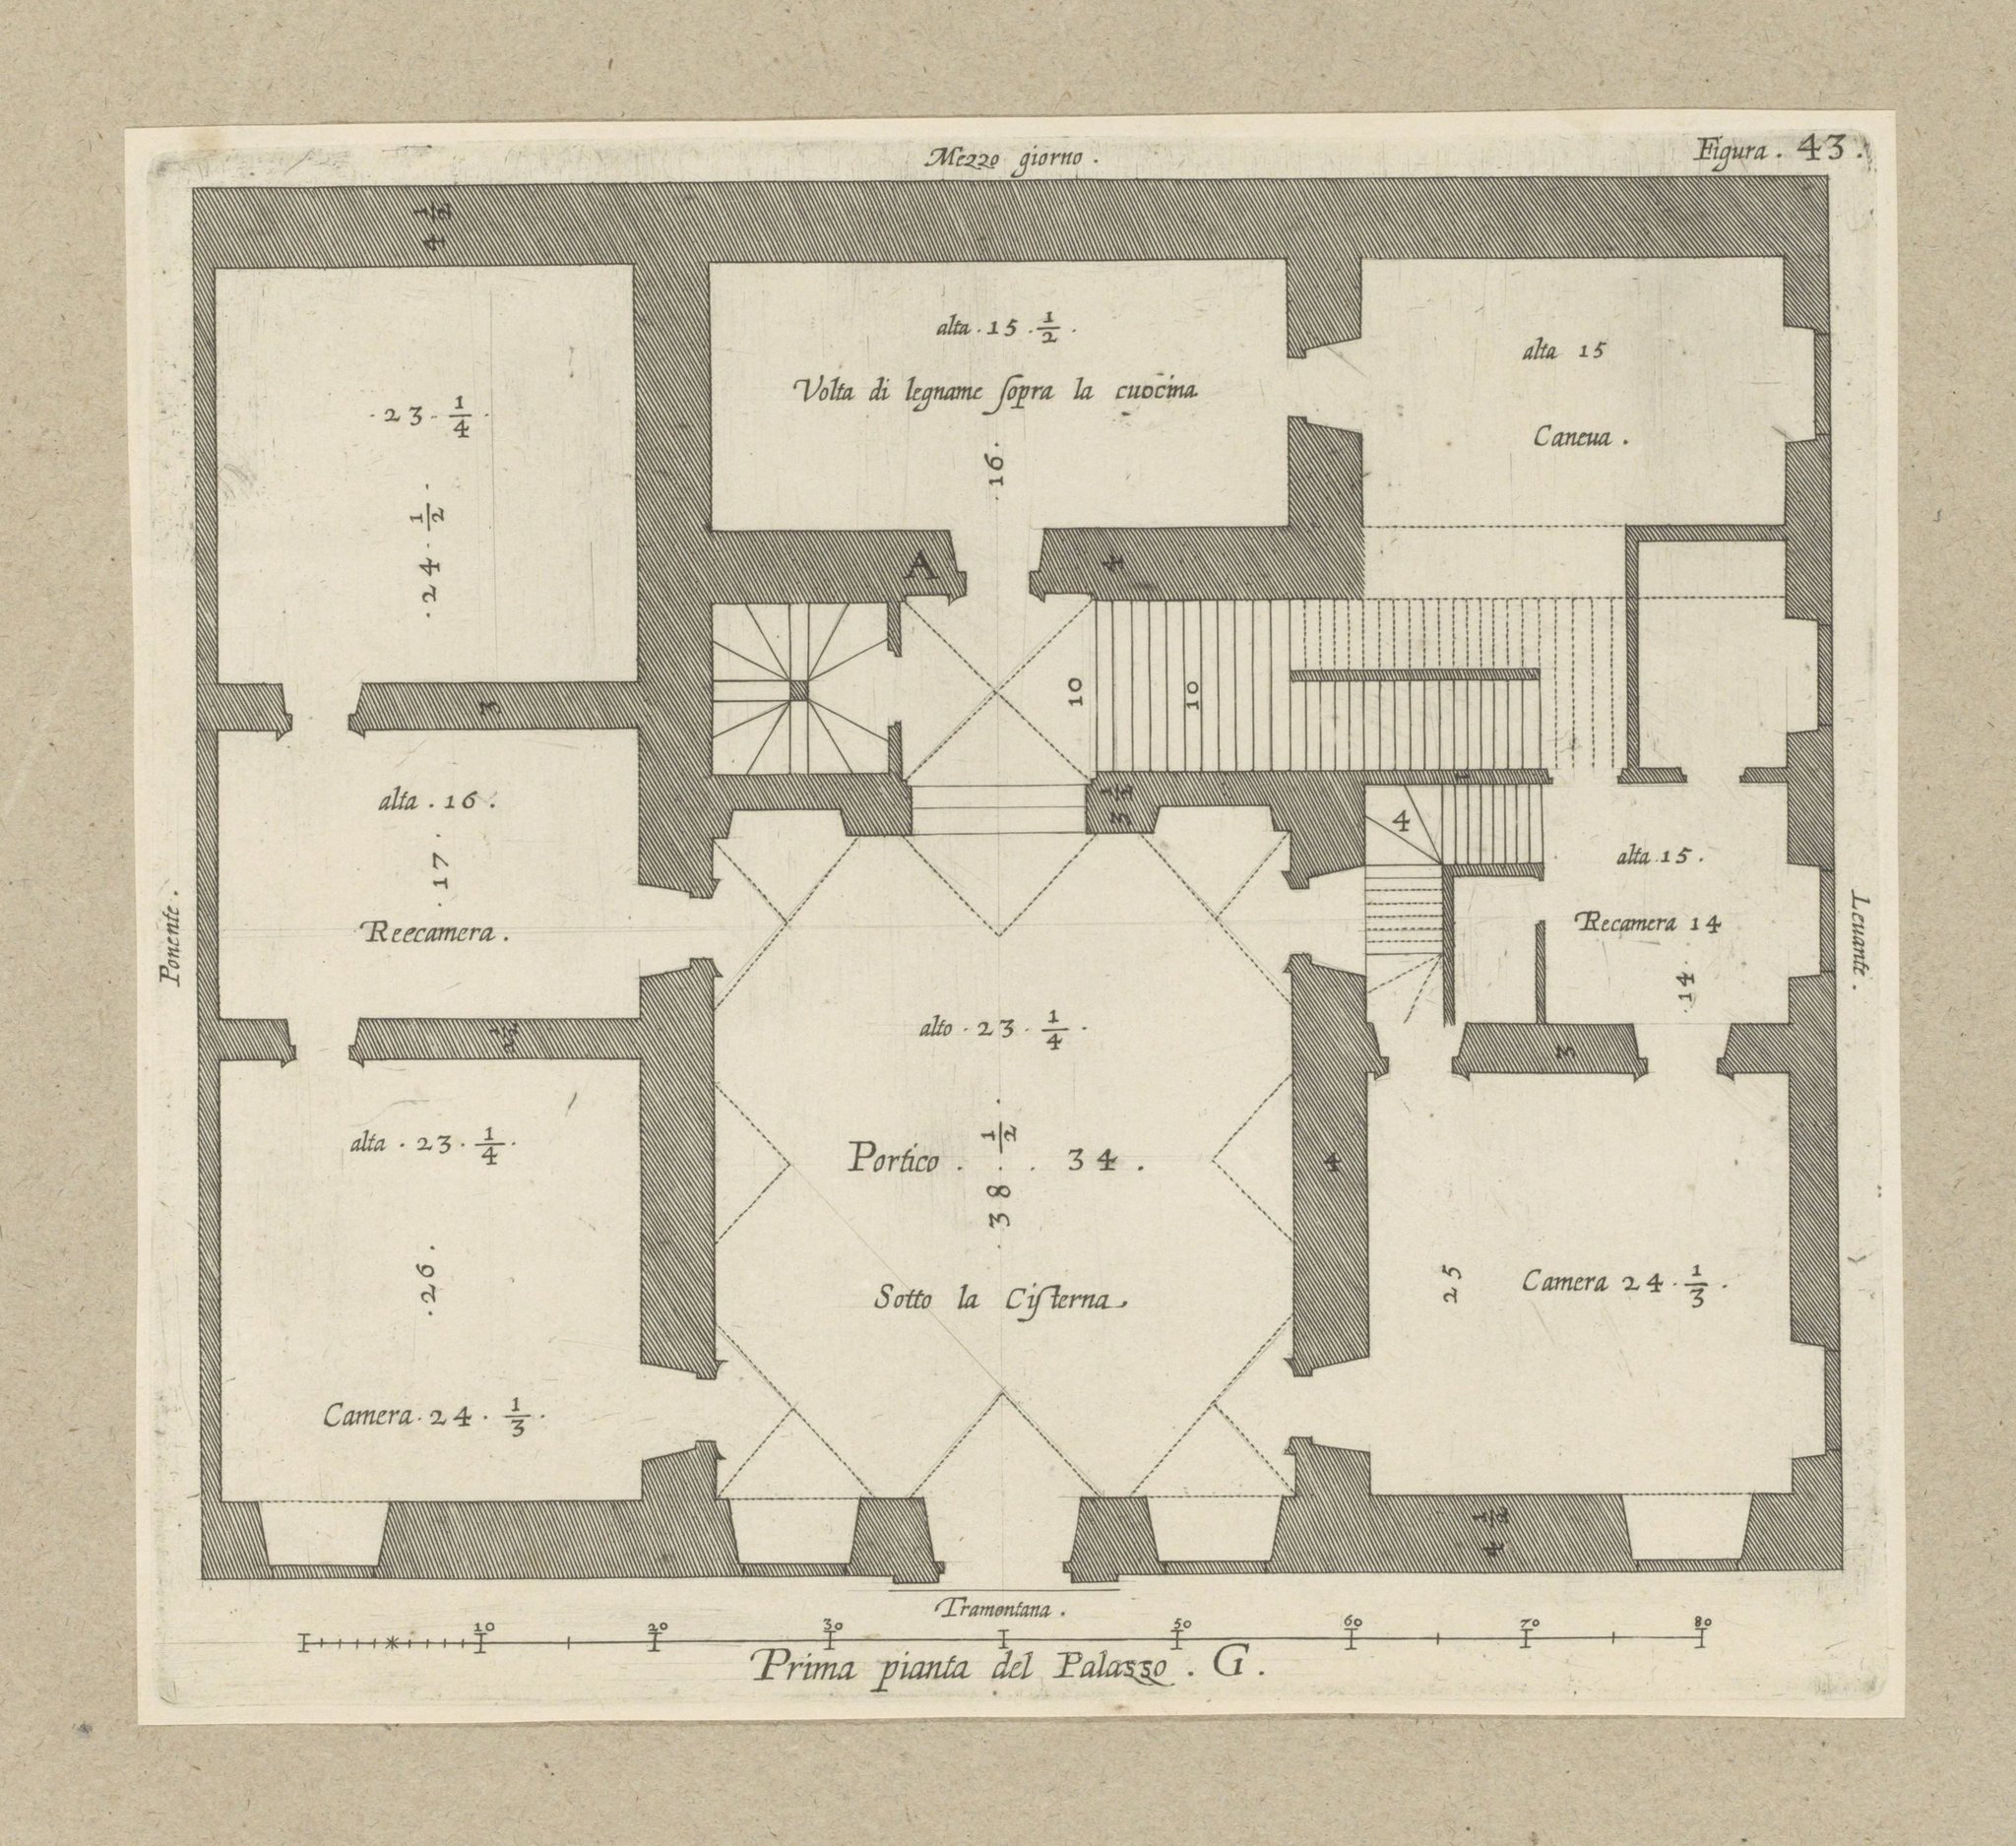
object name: print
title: Plattegrond van de begane grond van het Palazzo Interiano Pallavicini te Genua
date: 1622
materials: paper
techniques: engraving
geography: antwerp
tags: hôtel, i.e. small palace in city - aa - civic architecture: inside, plan ~ architecture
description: Deze prent maakt deel uit van een album.